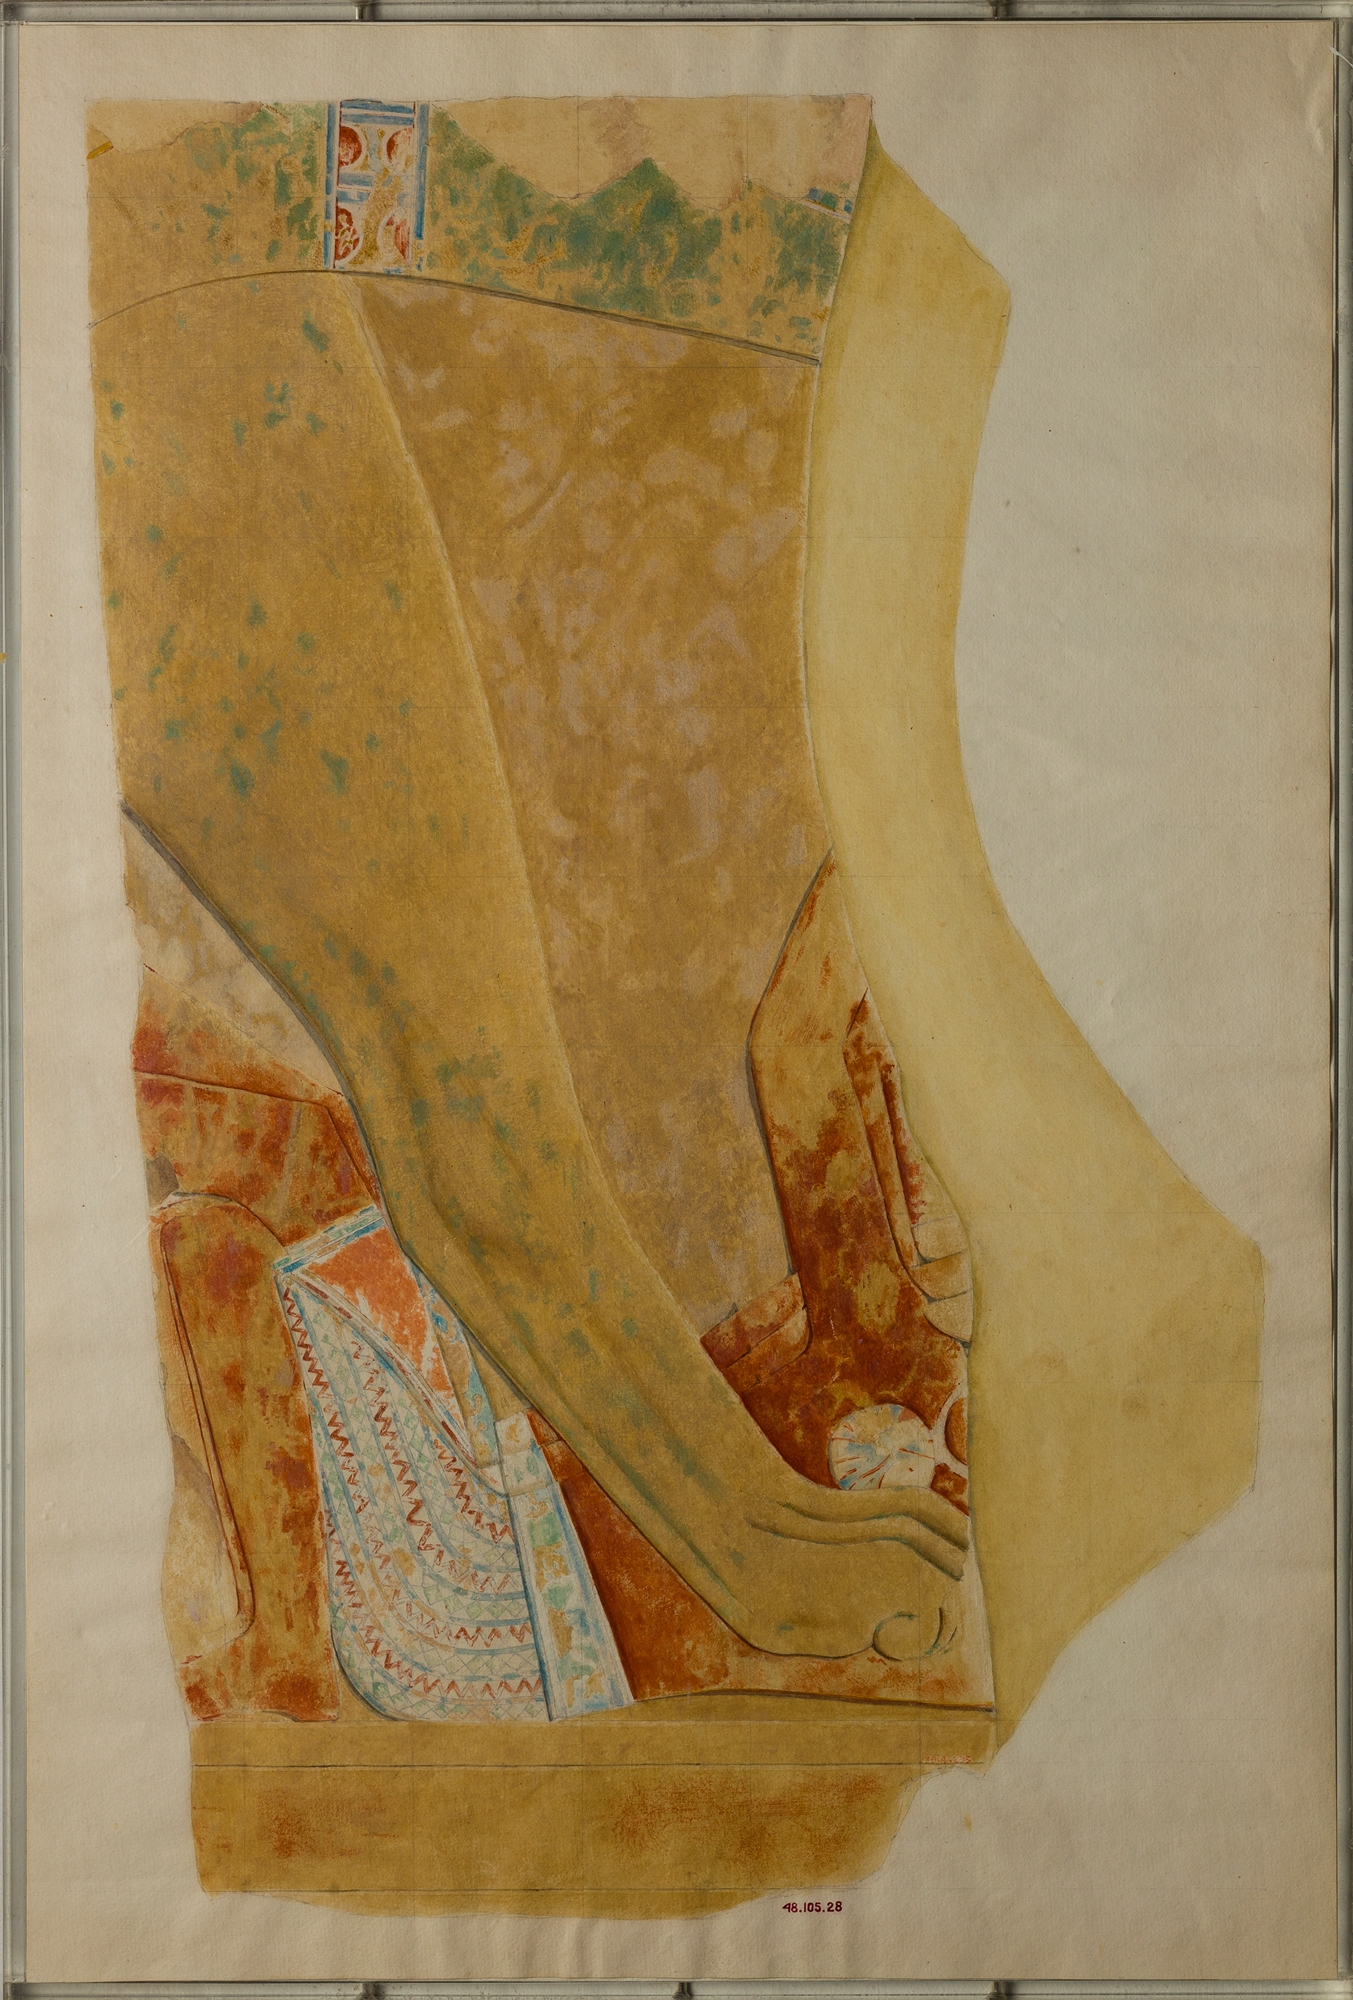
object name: facsimile, mentuhotep ii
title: Facsimile painting from the temple of Mentuhotep II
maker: charles k. wilkinson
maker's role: artist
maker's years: 1897-1986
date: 2051-2000 BCE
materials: paper, paint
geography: egypt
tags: feet